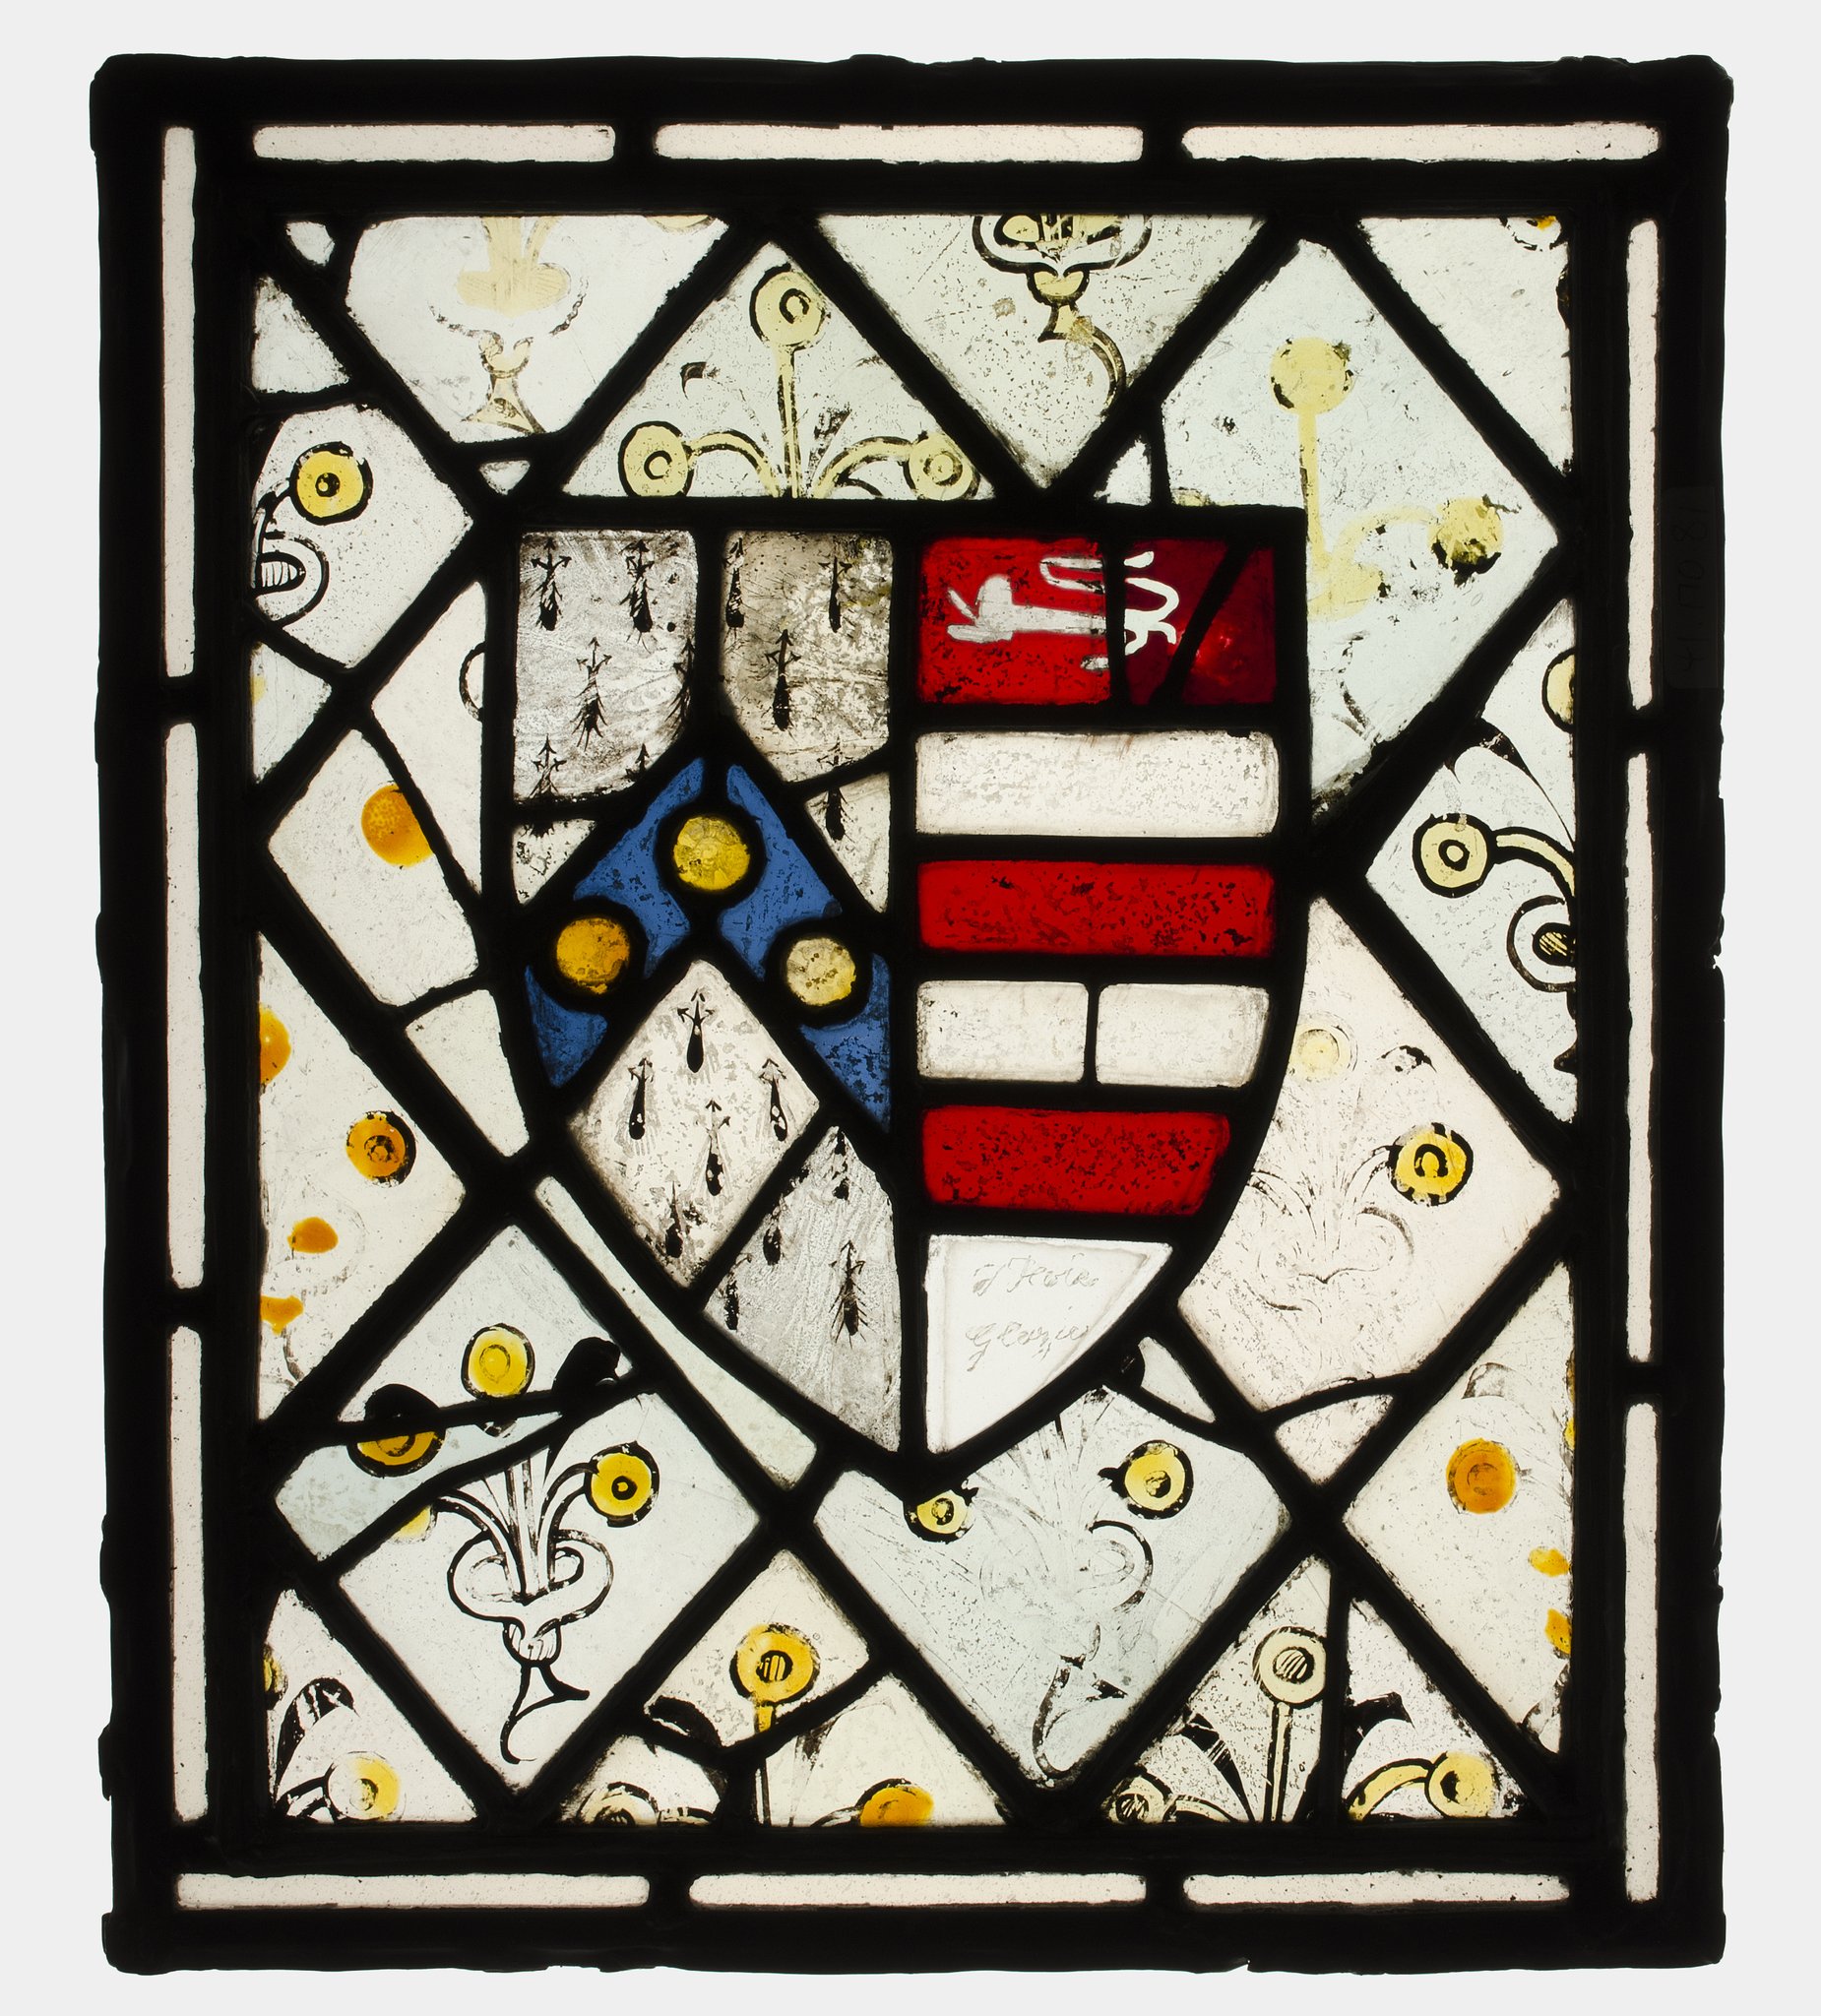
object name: panel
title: Panel with Heraldic Shield of Johnson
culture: british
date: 1500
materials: glass, metal, paint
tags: coat of arms